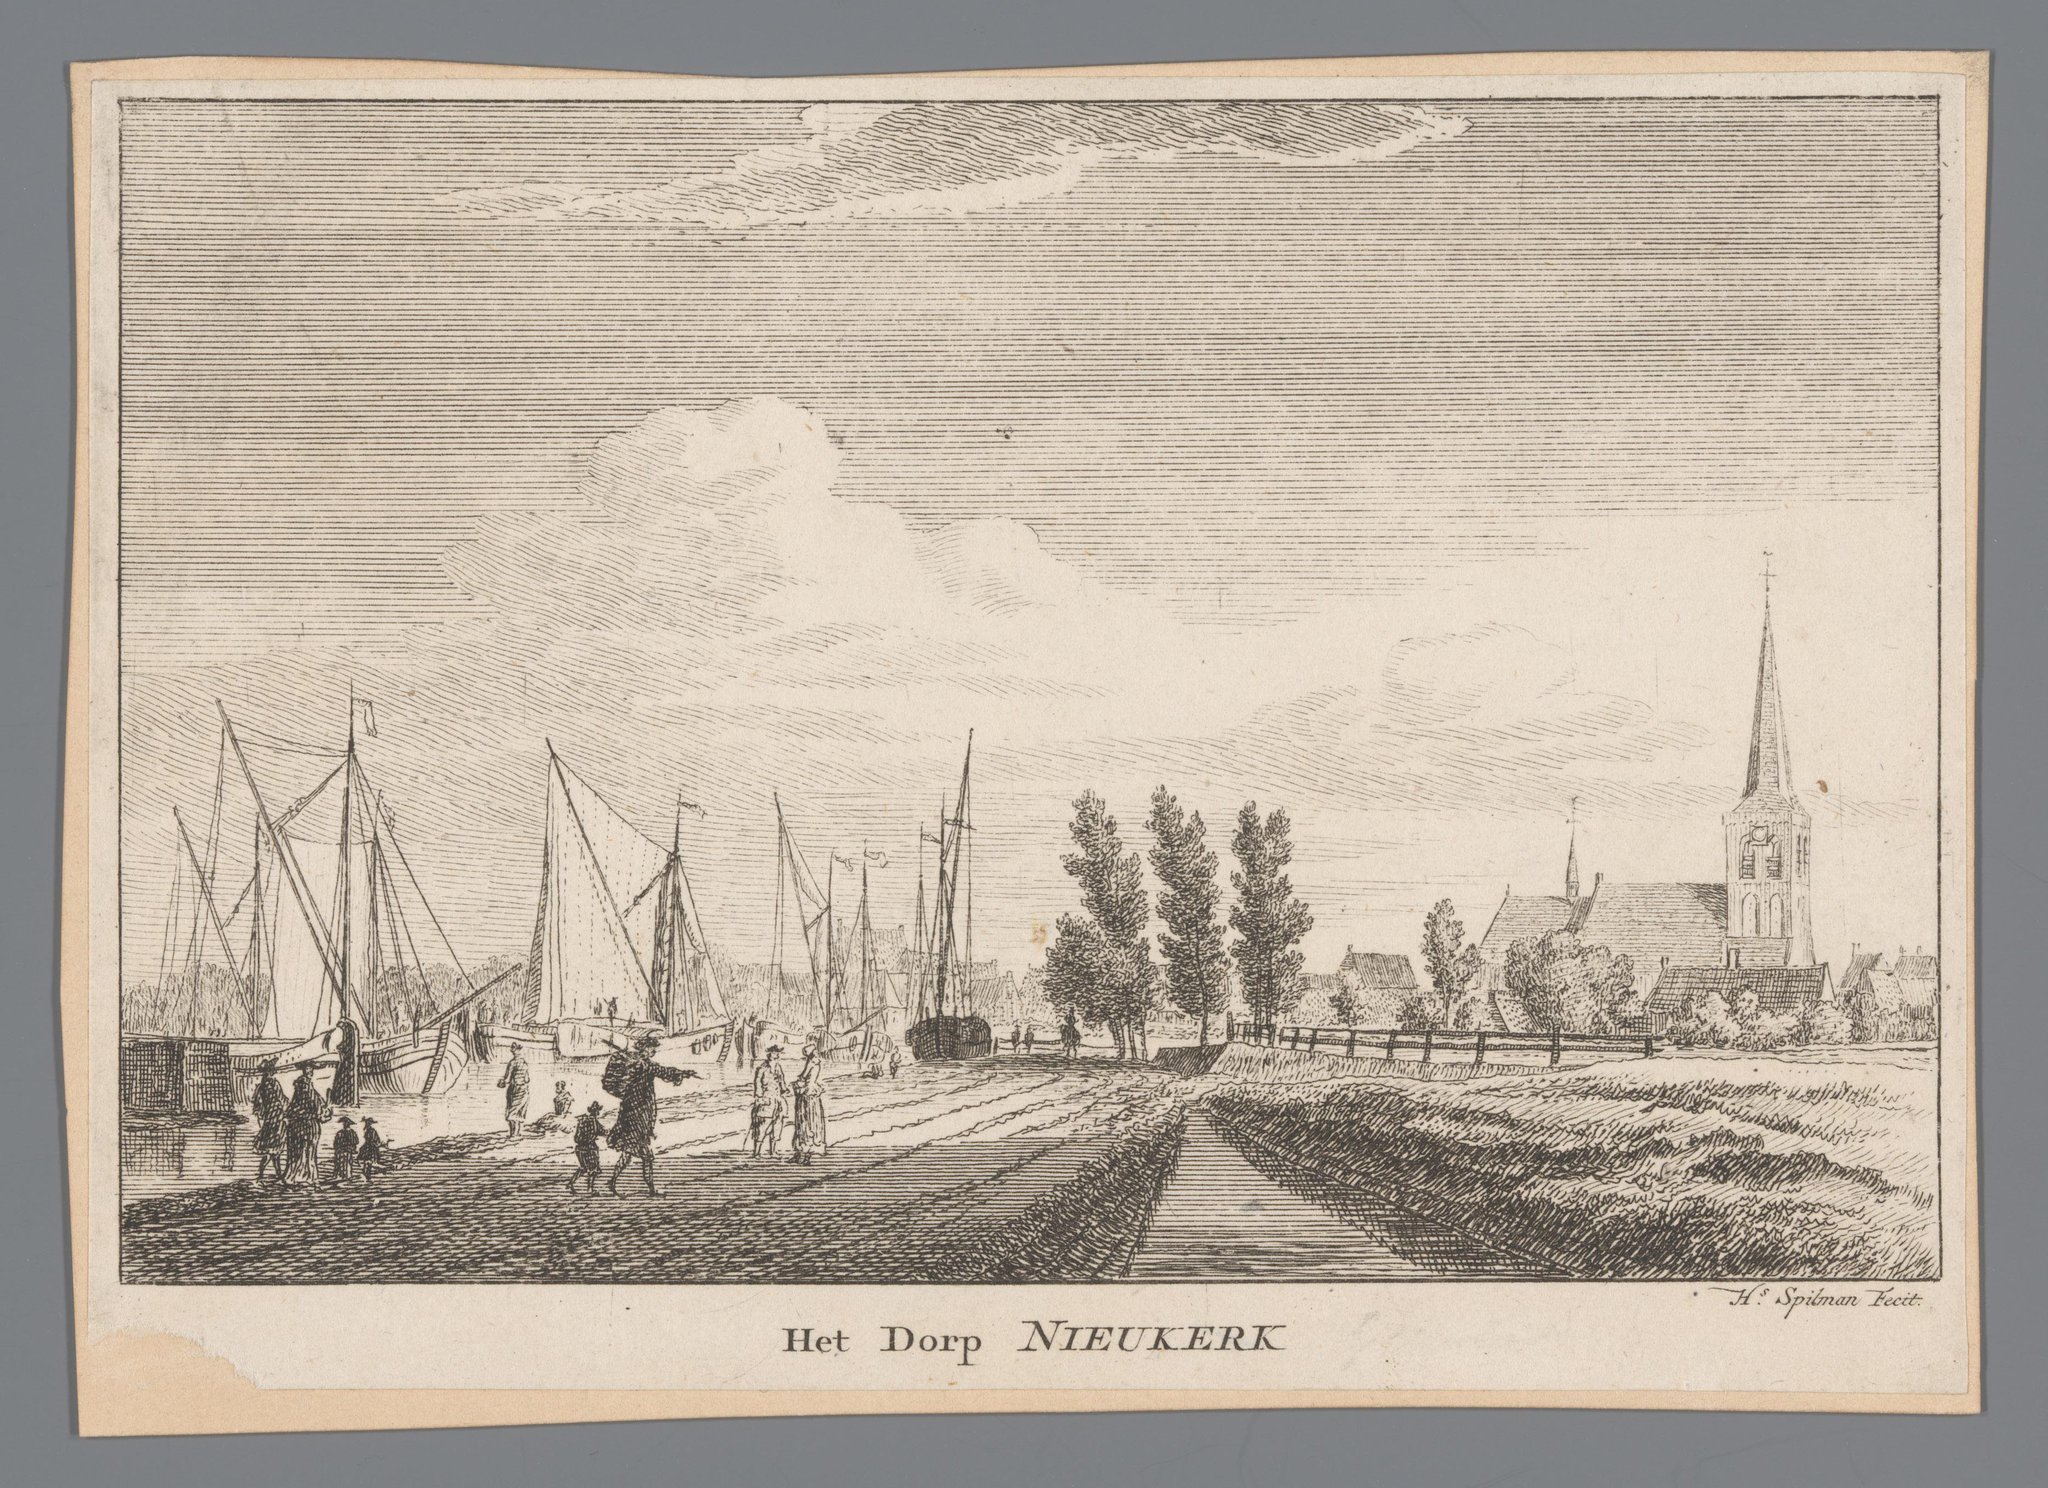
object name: print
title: Het dorp Nieukerk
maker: hendrik spilman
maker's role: draughtsman, painter, print maker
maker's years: 1721-1784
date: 1742-1784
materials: paper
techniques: engraving, etching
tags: sailing-ship, sailing-boat, village, church (exterior)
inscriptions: collector's mark: Lugt 2166